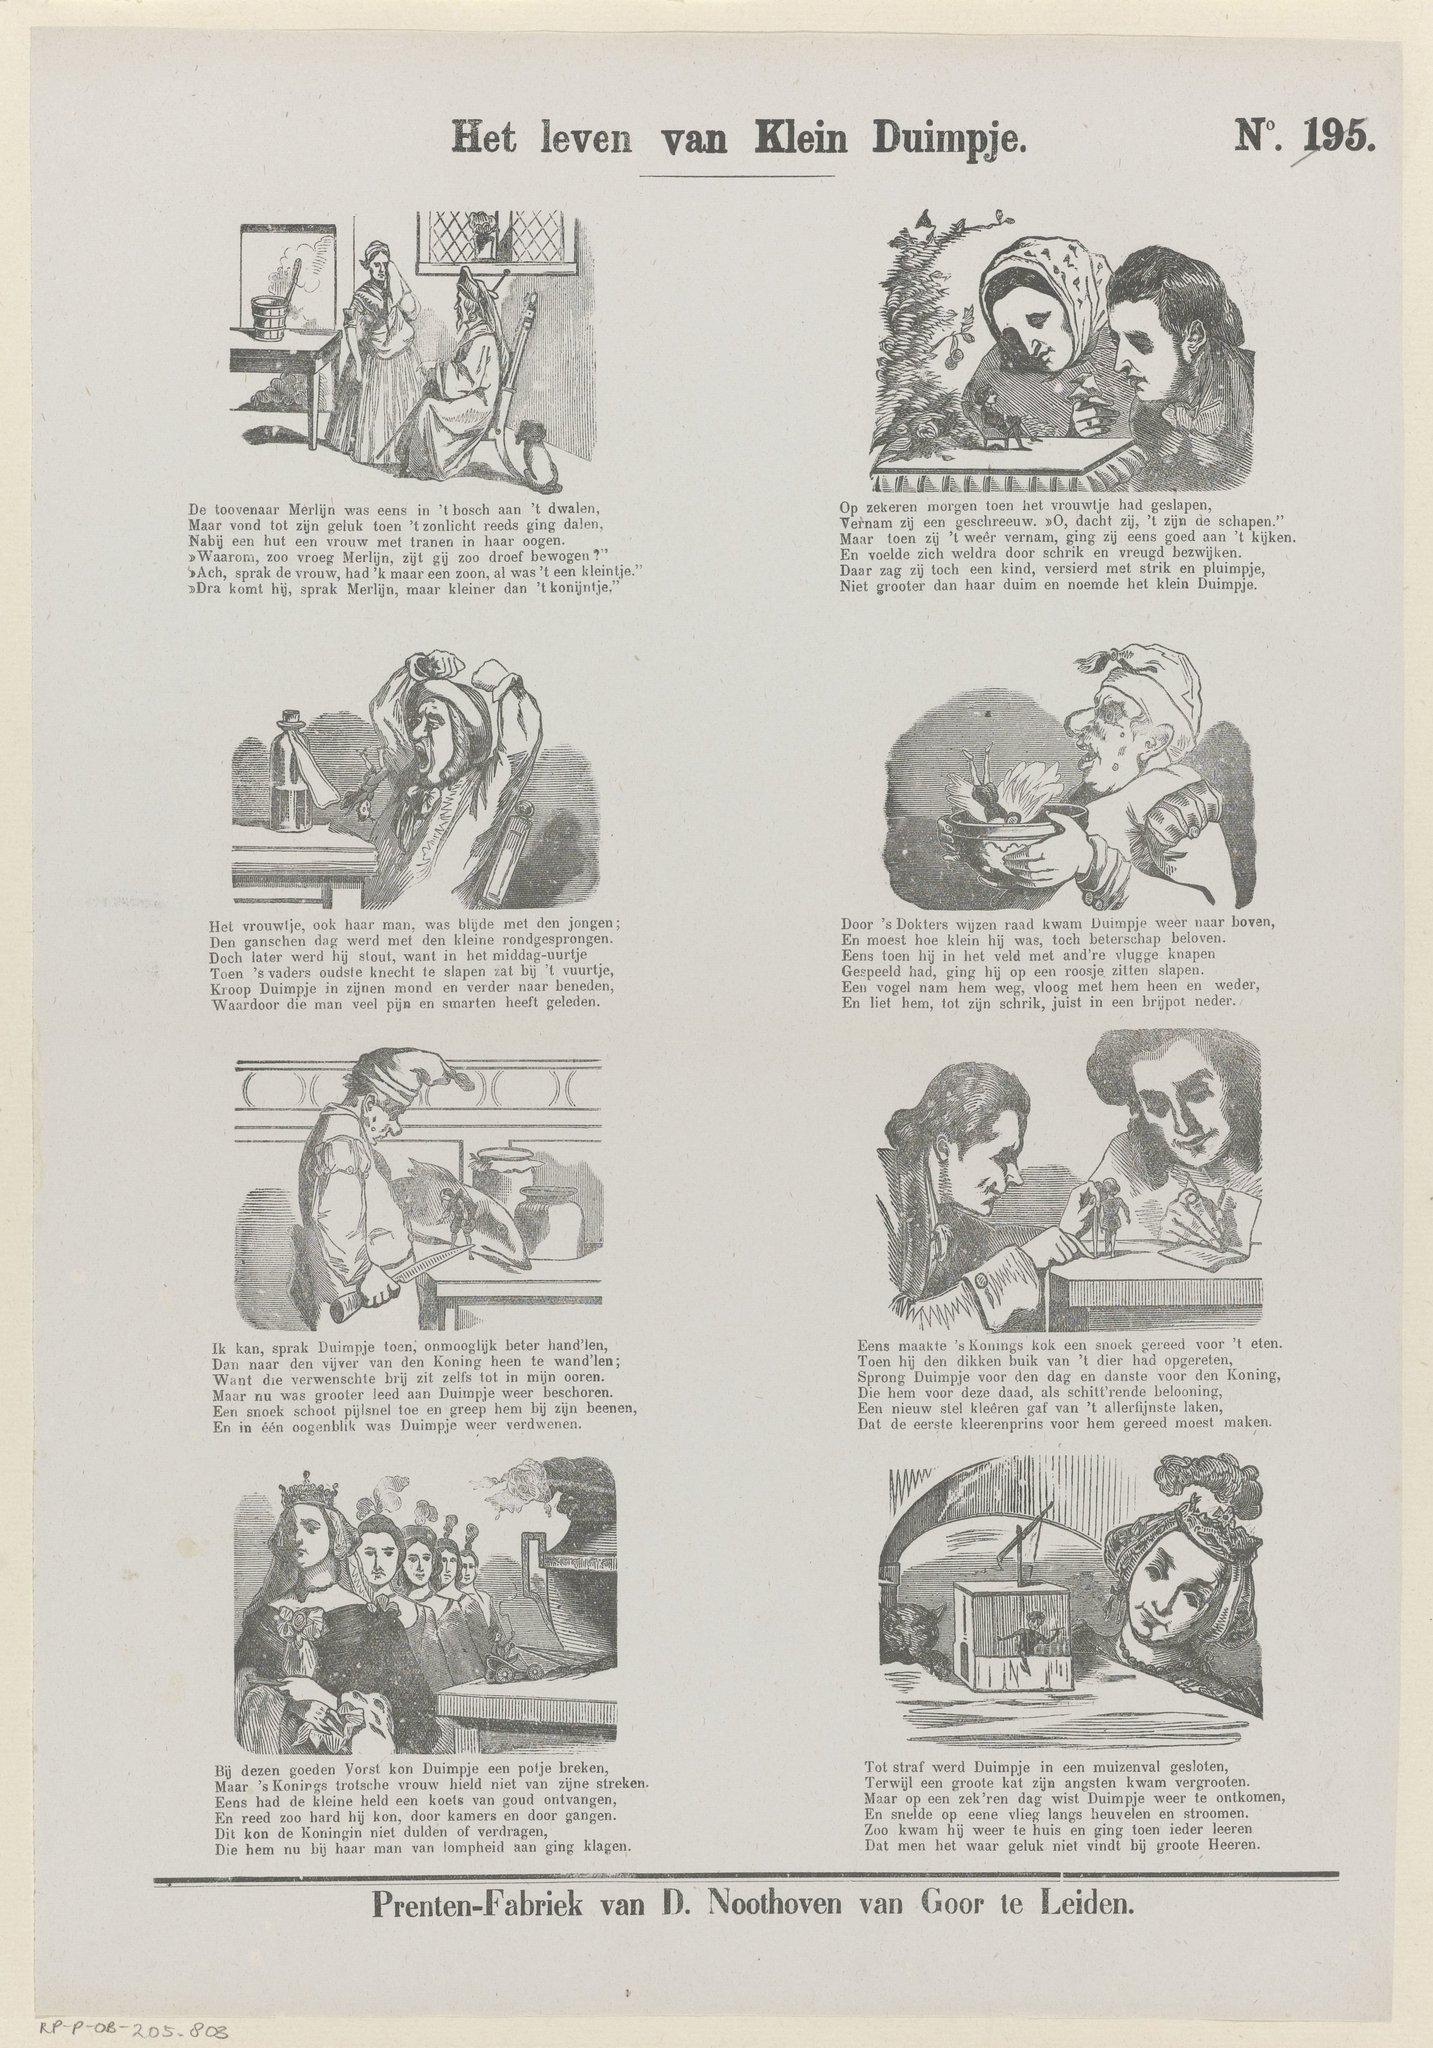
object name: print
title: Het leven van Klein Duimpje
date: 1850-1881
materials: paper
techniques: letterpress printing, engraving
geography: leiden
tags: tales and fairy tales: little thumbling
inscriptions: collector's mark: Lugt 2760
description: Blad met 8 voorstellingen uit het sprookje van Klein Duimpje. Onder elke voorstelling een zesregelig vers. Genummerd rechtsboven: No. 195.